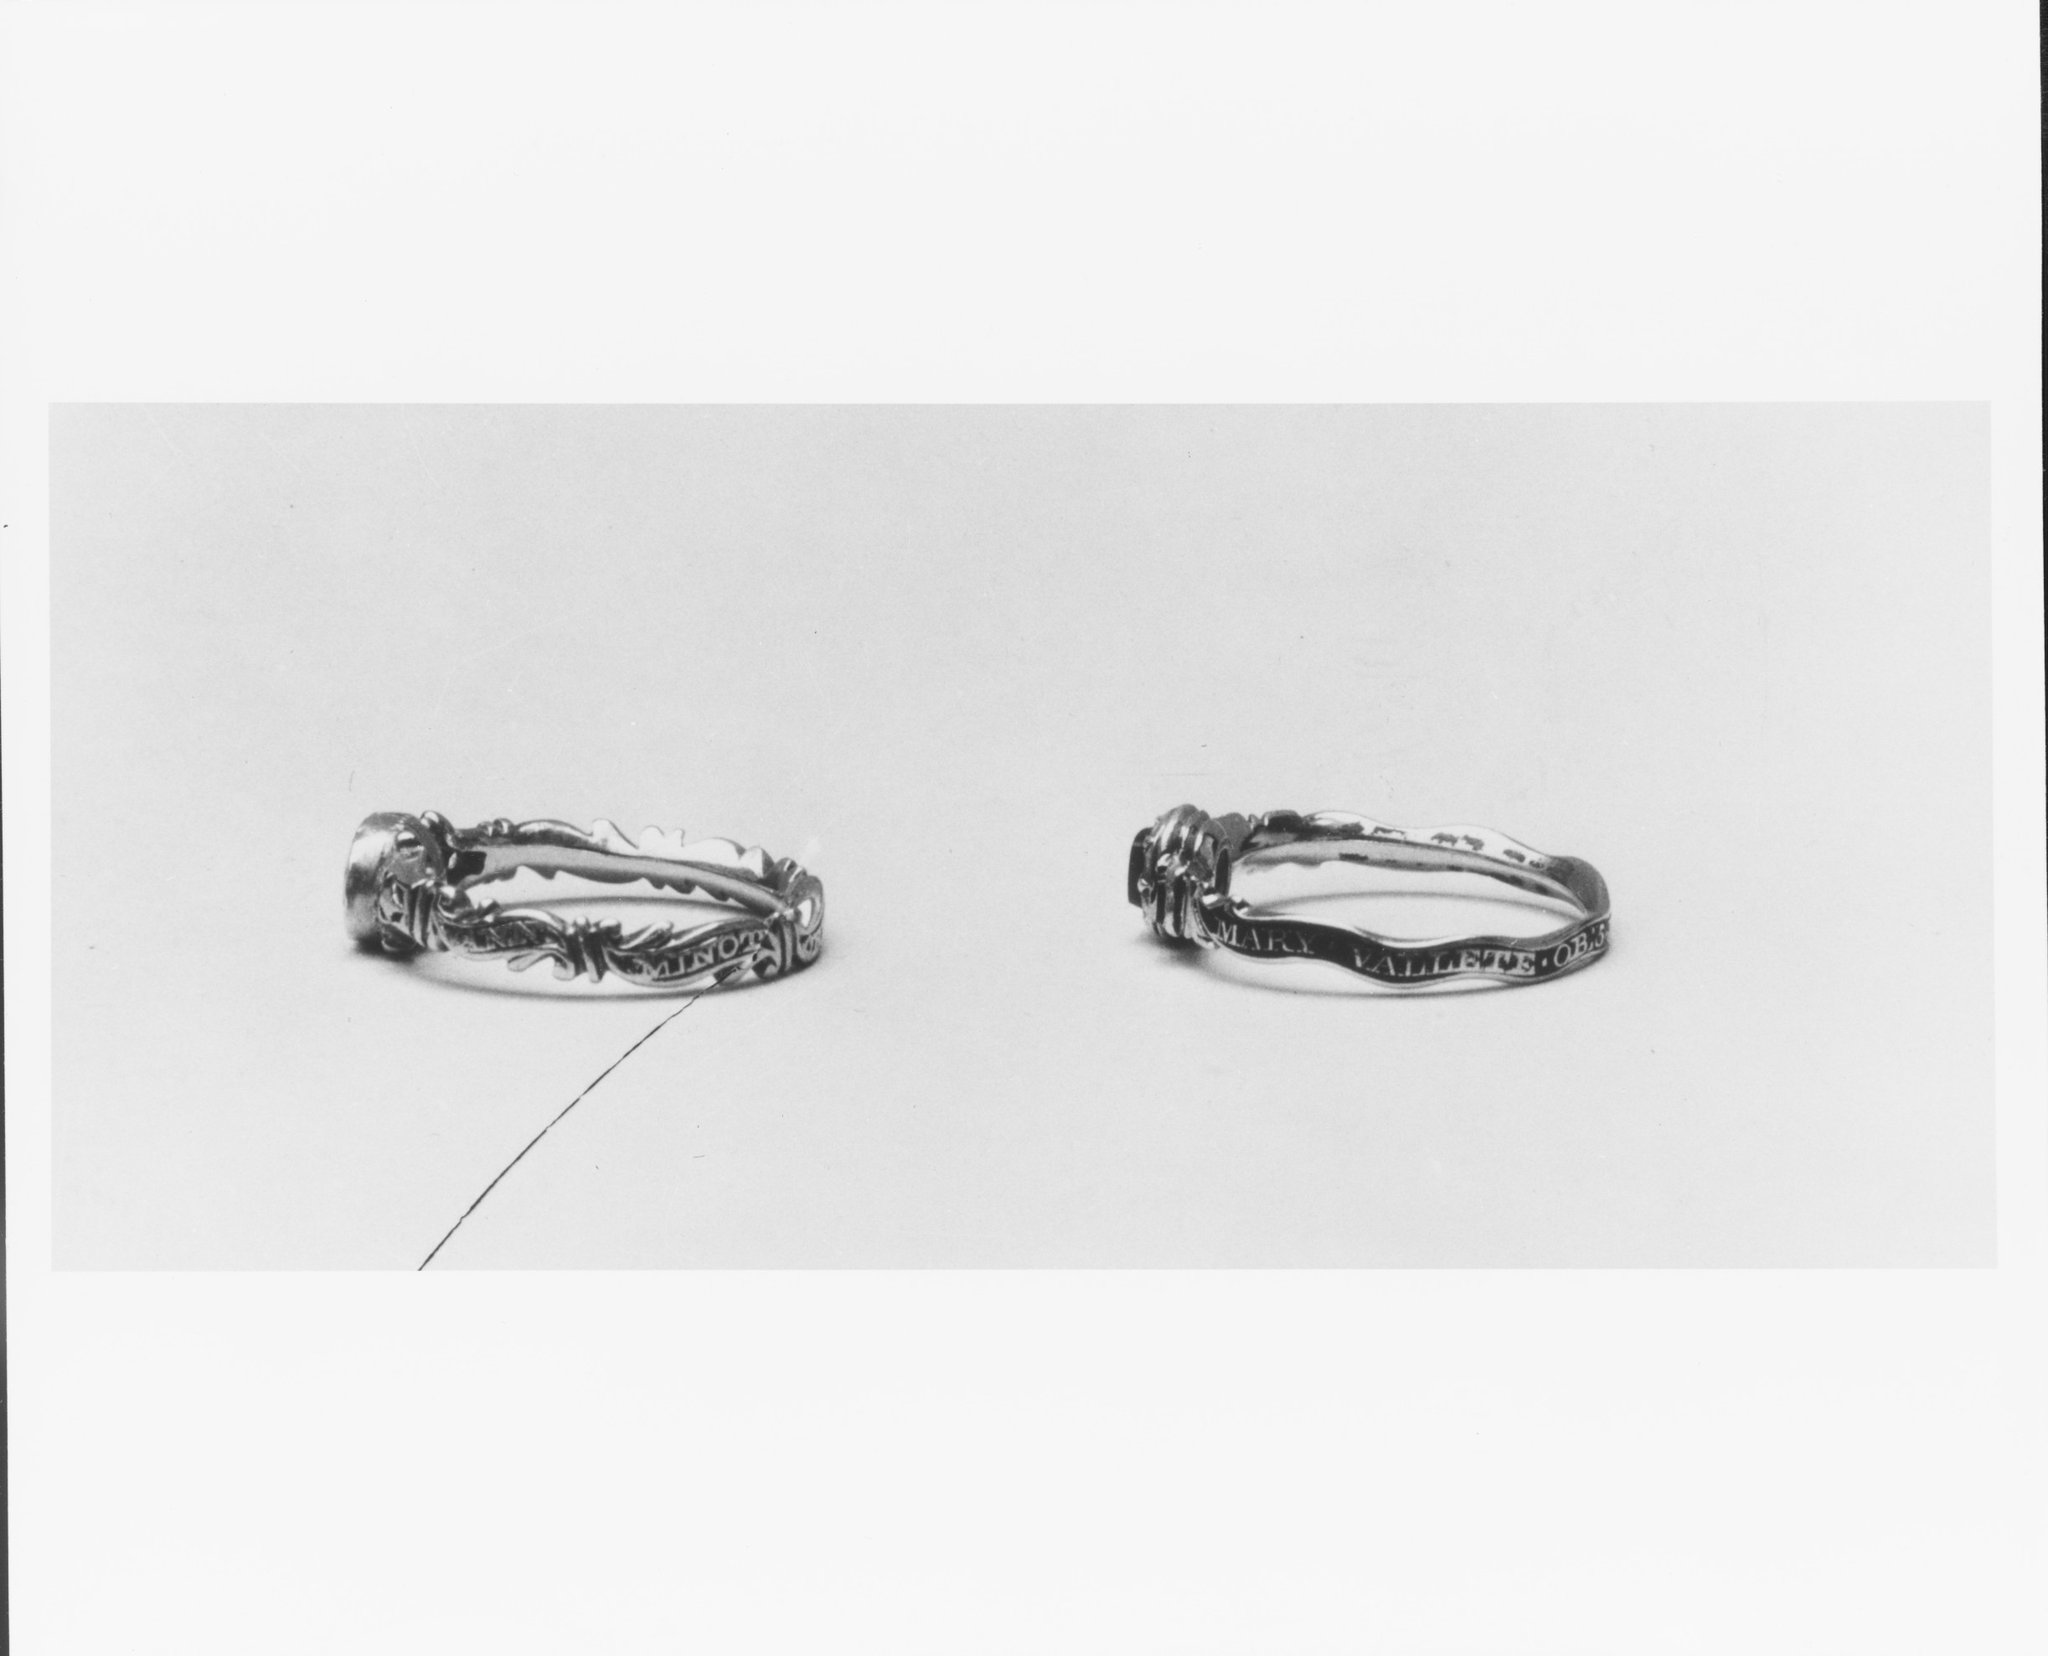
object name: ring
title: Mourning Ring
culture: american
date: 1762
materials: enamel, gold, onyx, silver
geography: united states